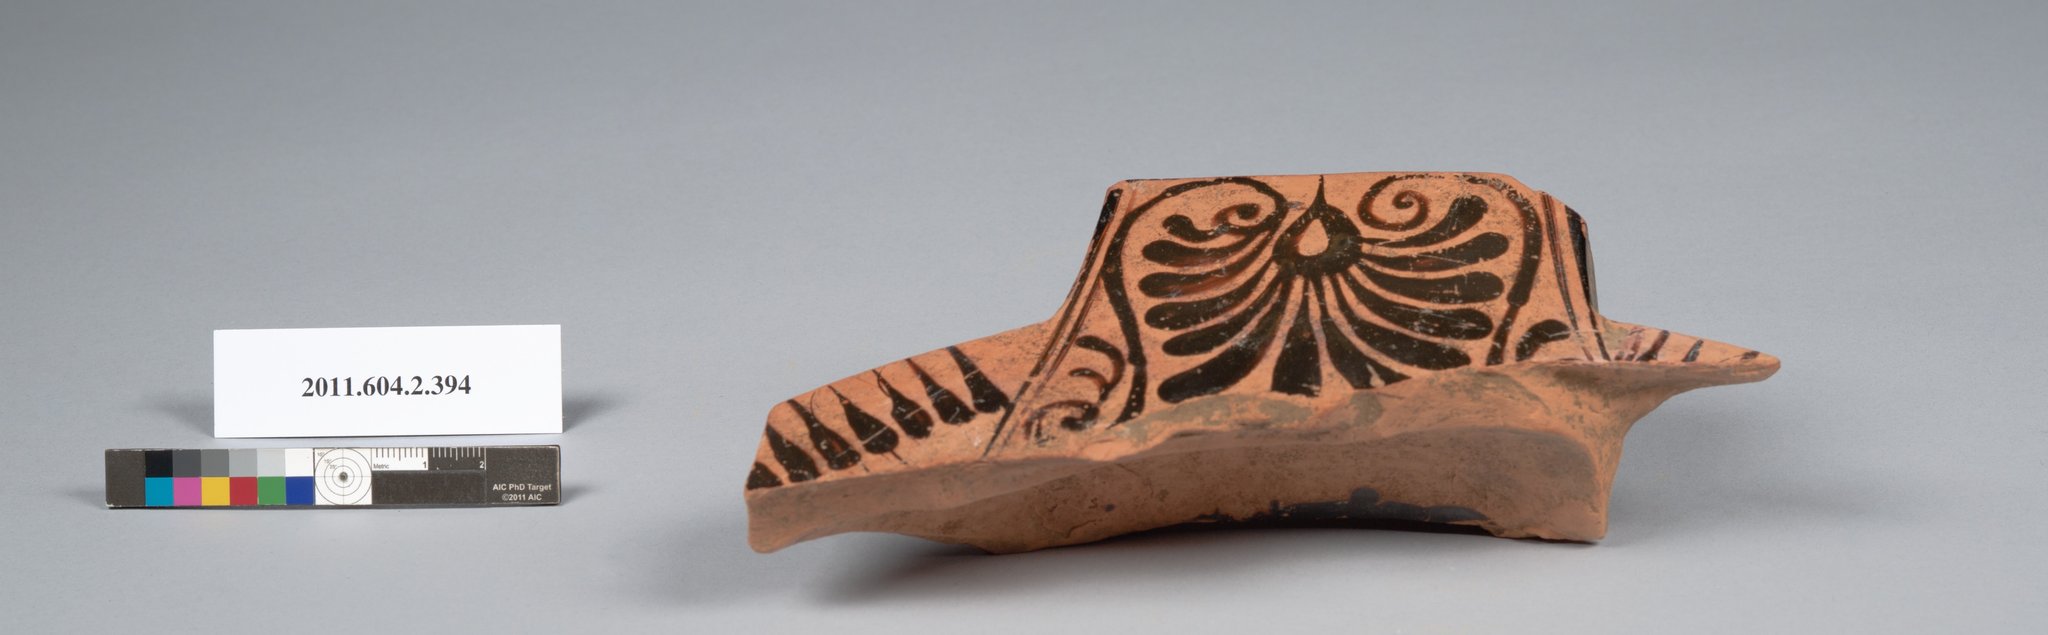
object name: column krater fragment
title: Terracotta fragment of a column-krater (bowl for mixing wine and water)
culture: greek, attic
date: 450-430 BCE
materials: terracotta